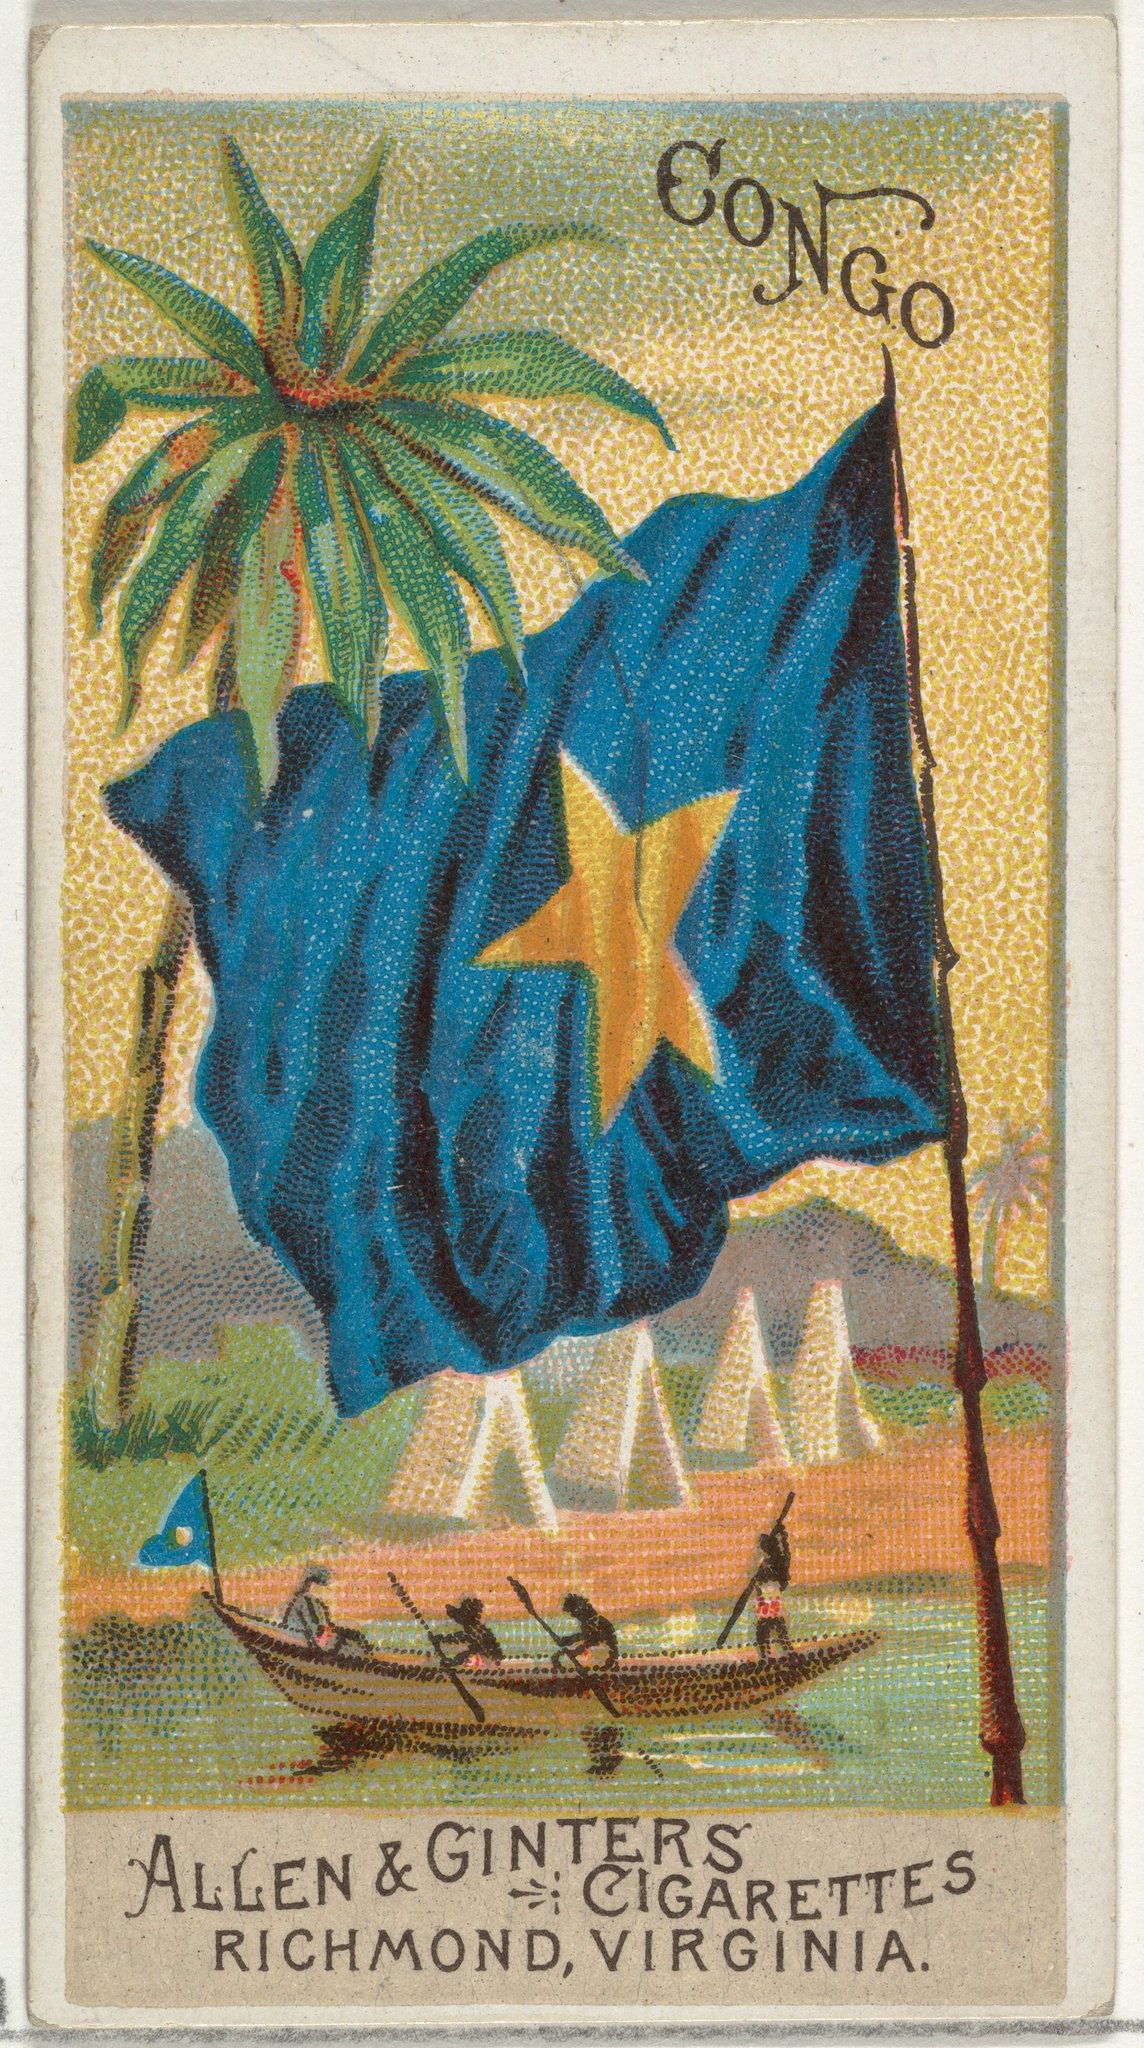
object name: print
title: Congo, from Flags of All Nations, Series 2 (N10) for Allen & Ginter Cigarettes Brands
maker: allen & ginter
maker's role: publisher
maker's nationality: american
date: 1890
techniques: color lithograph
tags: flags